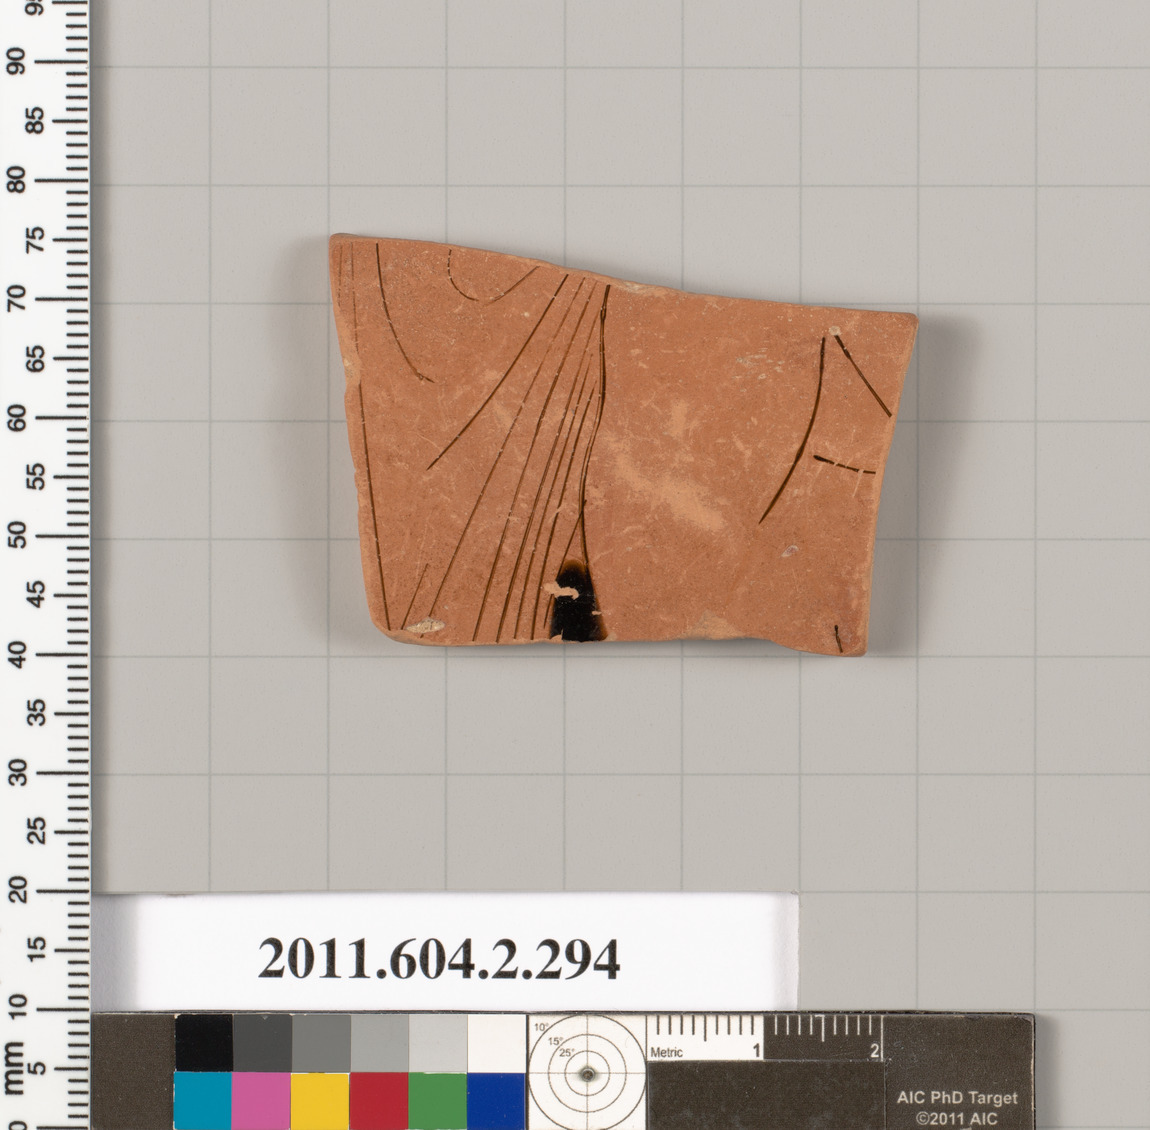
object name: column krater fragment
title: Terracotta fragment of a column-krater (bowl for mixing wine and water)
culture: greek, attic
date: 450-426 BCE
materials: terracotta